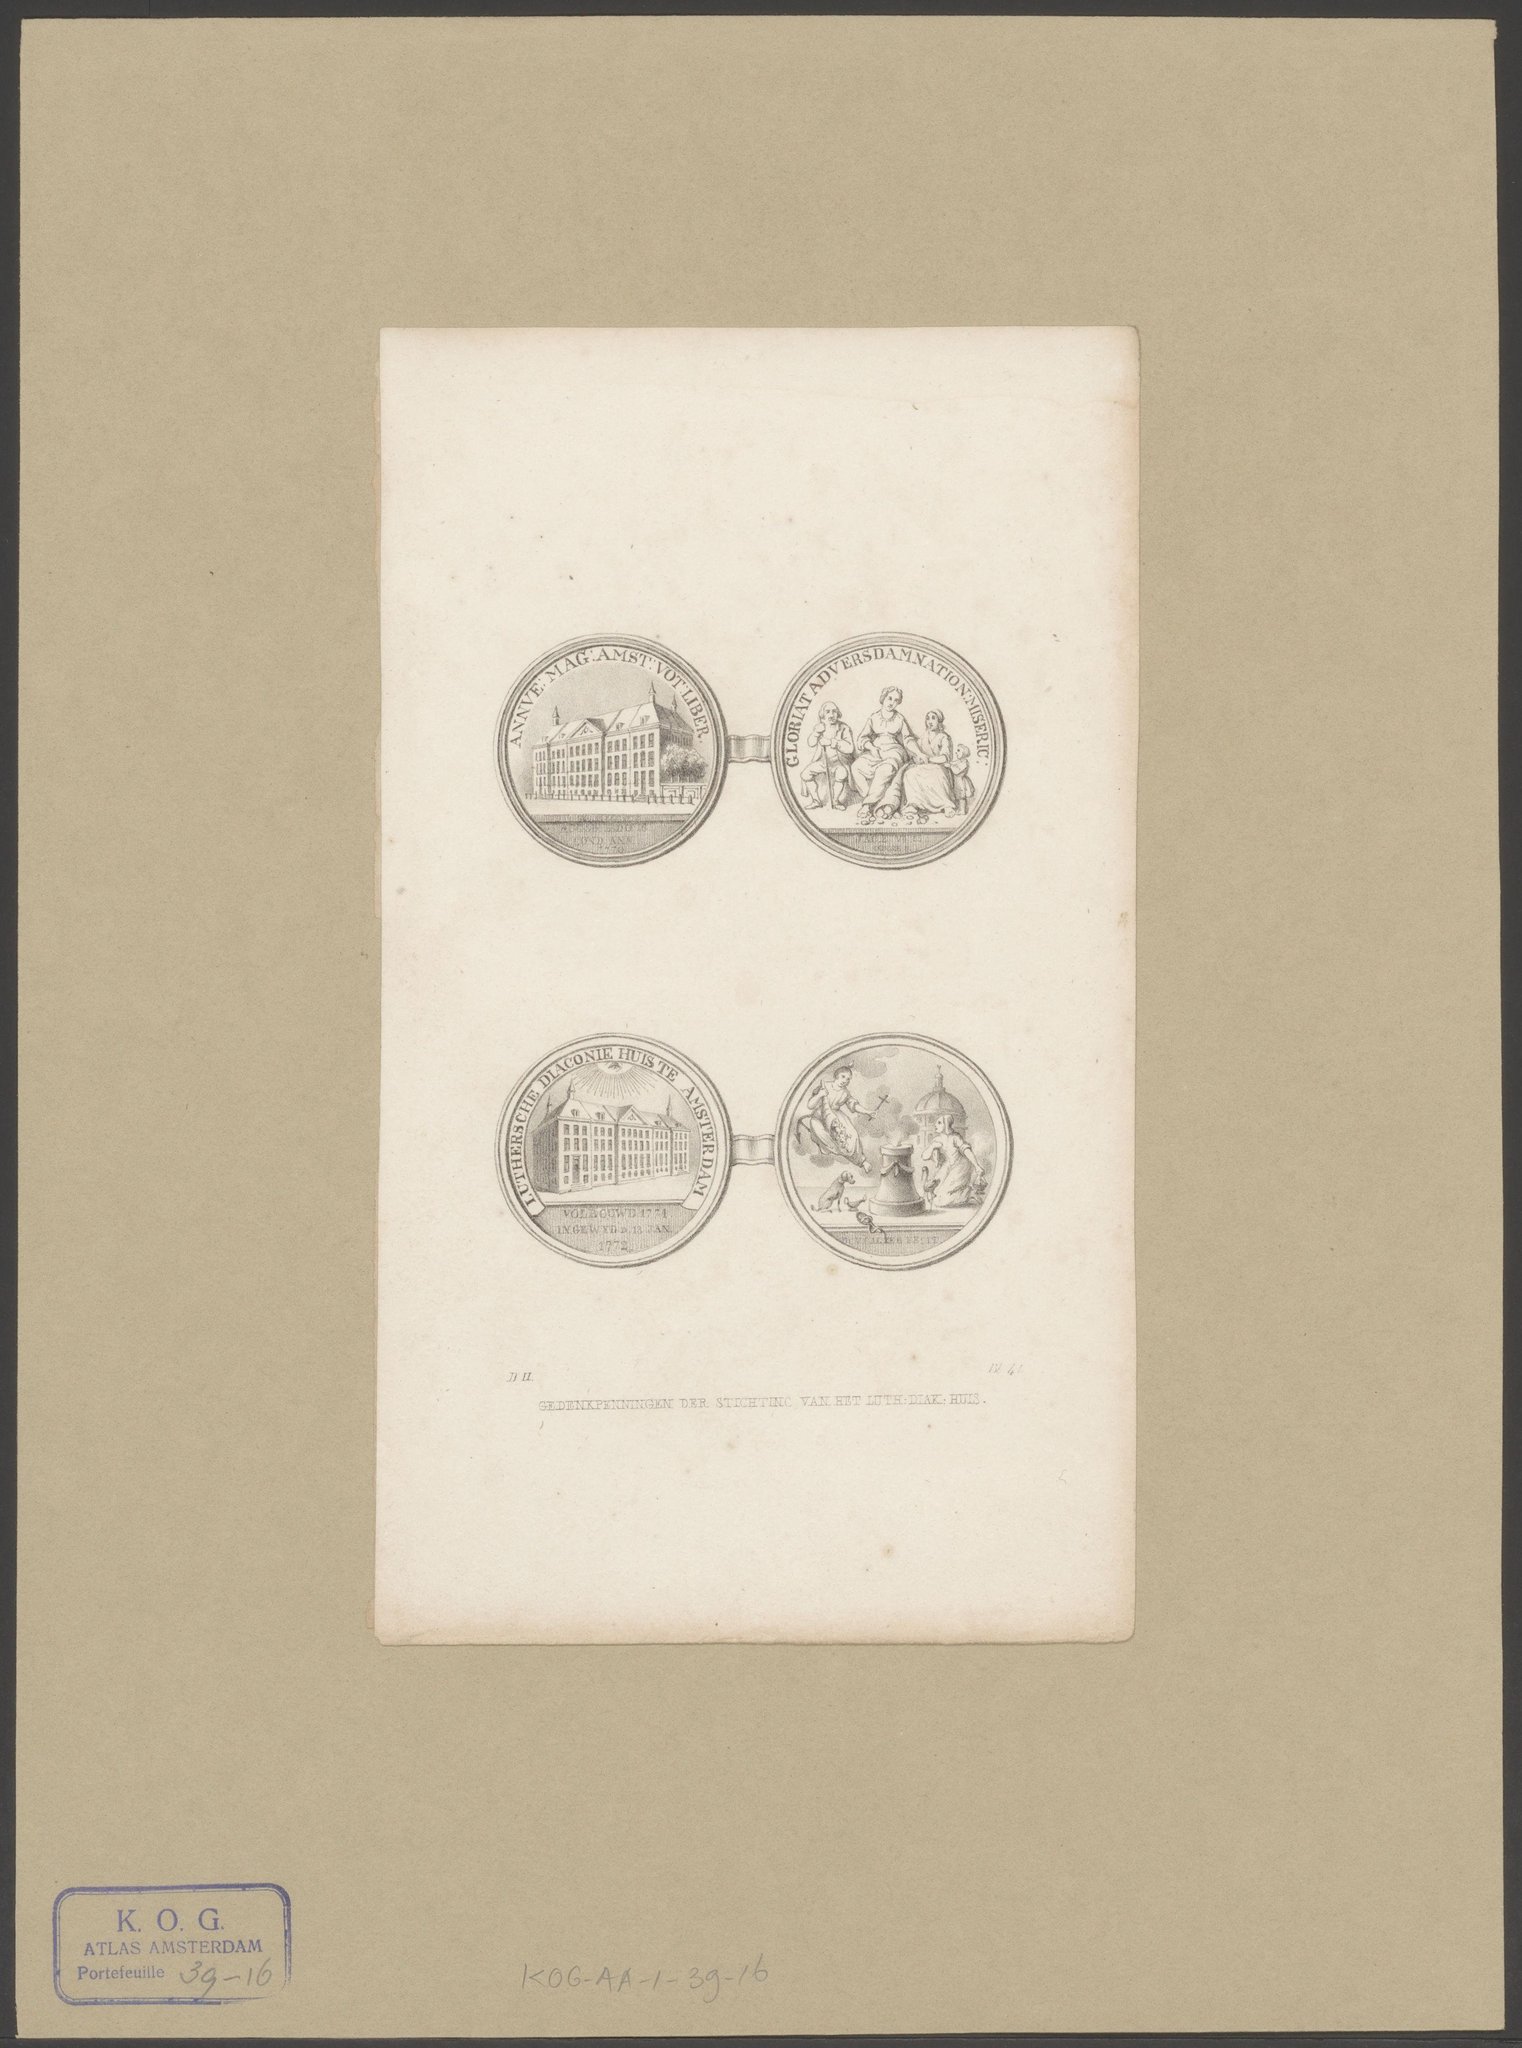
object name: print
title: Penningen voor de inwijding van het Lutherse Diaconiehuis te Amsterdam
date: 1845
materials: paper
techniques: lithograph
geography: netherlands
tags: medal (considered as a piece of sculpture, regardless of its specific function)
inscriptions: collector's mark: Lugt 1641b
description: Onderaan: D II. / Bl. 41. Onderwerpsrubriek binnen de Atlas Amsterdam: Armwezen en liefdadige instellingen: II. Kerkelijke inrichtingen: Inrichtingen der Evang. Luthersen.